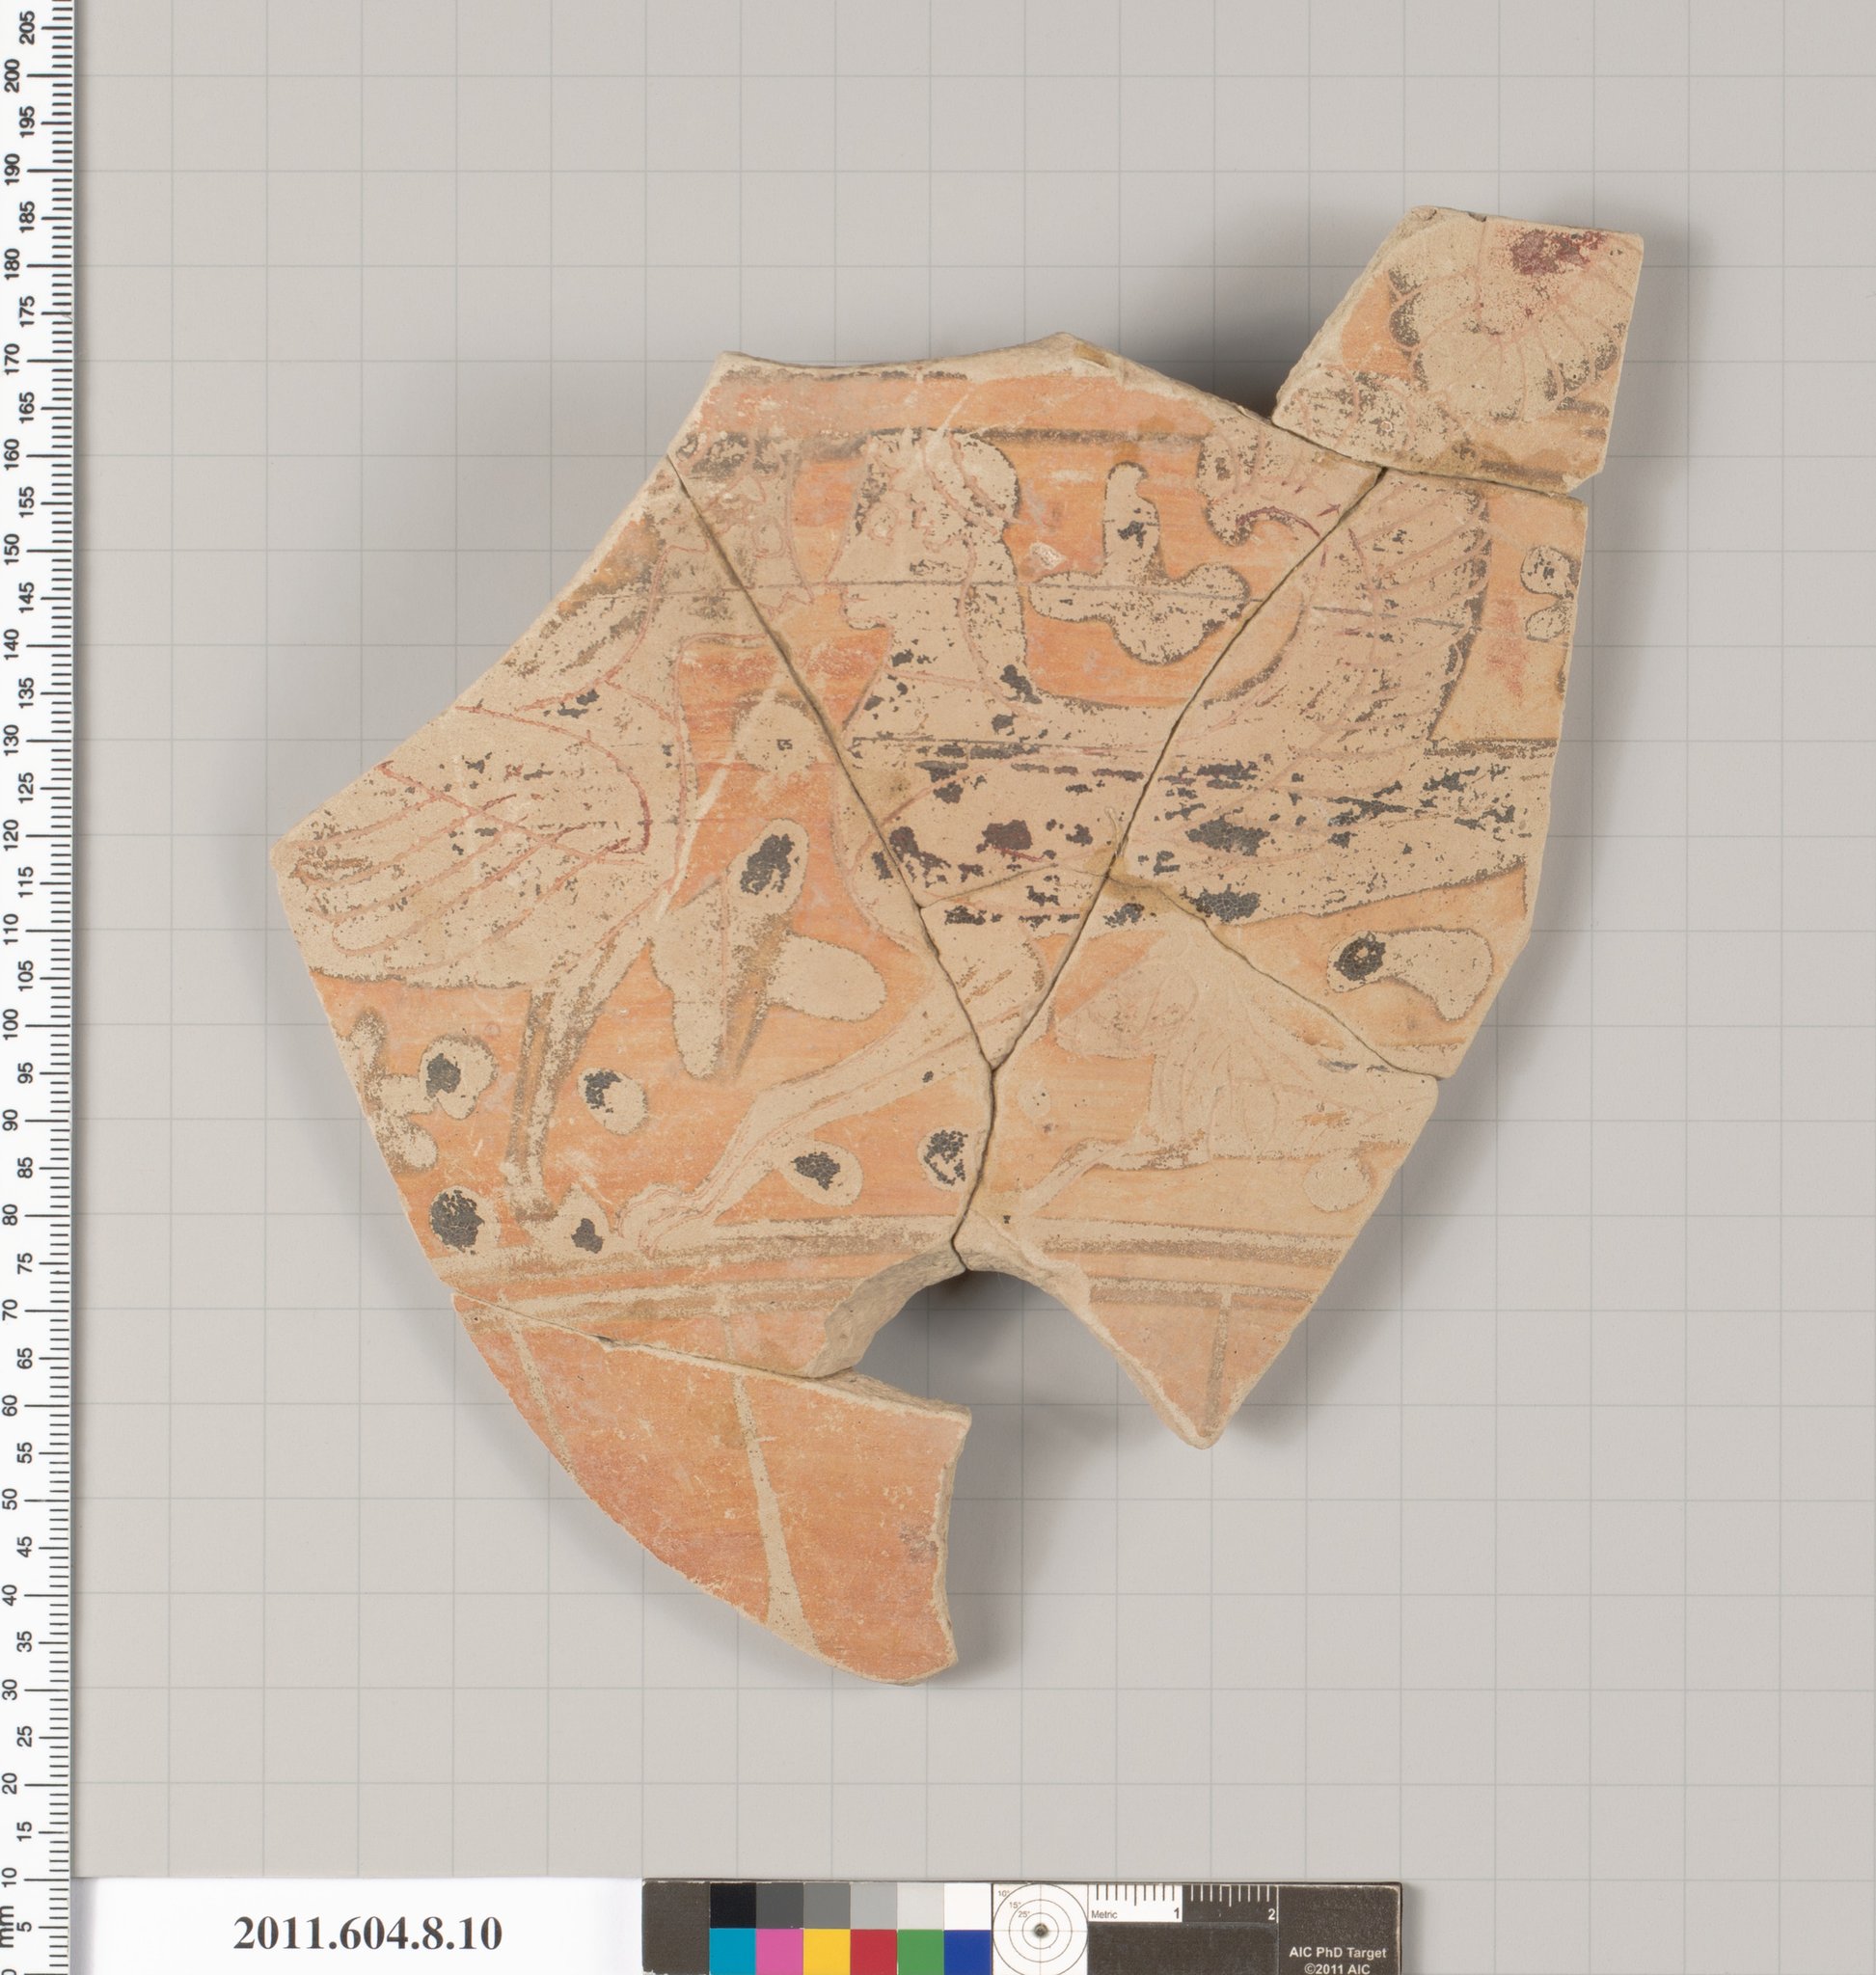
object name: amphora fragment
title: Terracotta fragment of an amphora (jar)?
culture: greek, corinthian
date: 600-501 BCE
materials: terracotta